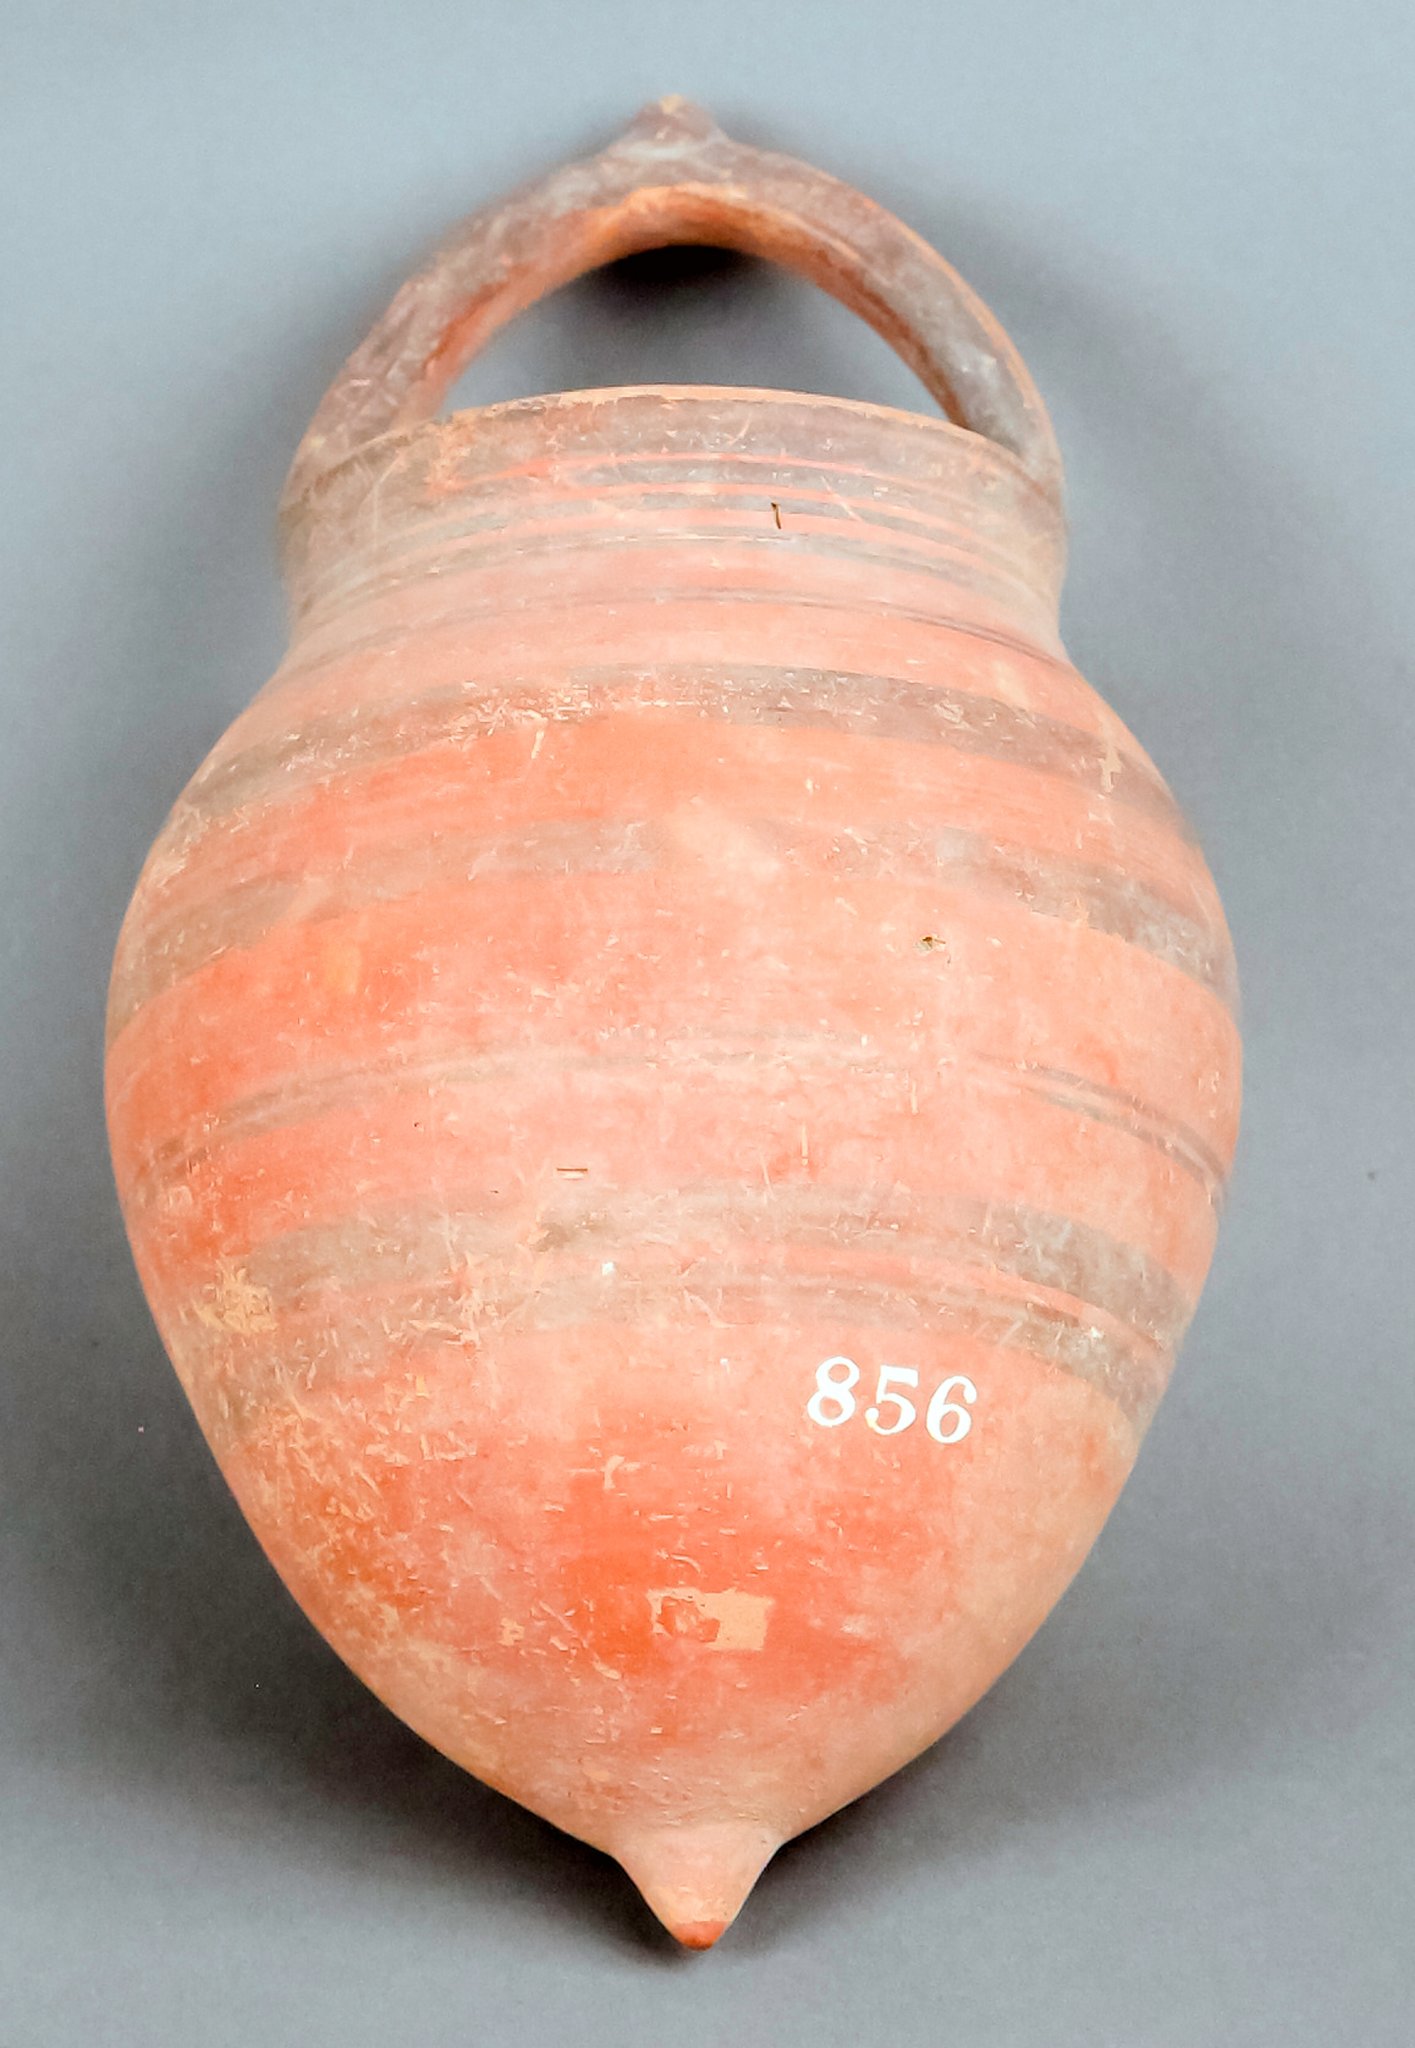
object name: amphoriskos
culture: cypriot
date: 850-750 BCE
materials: terracotta